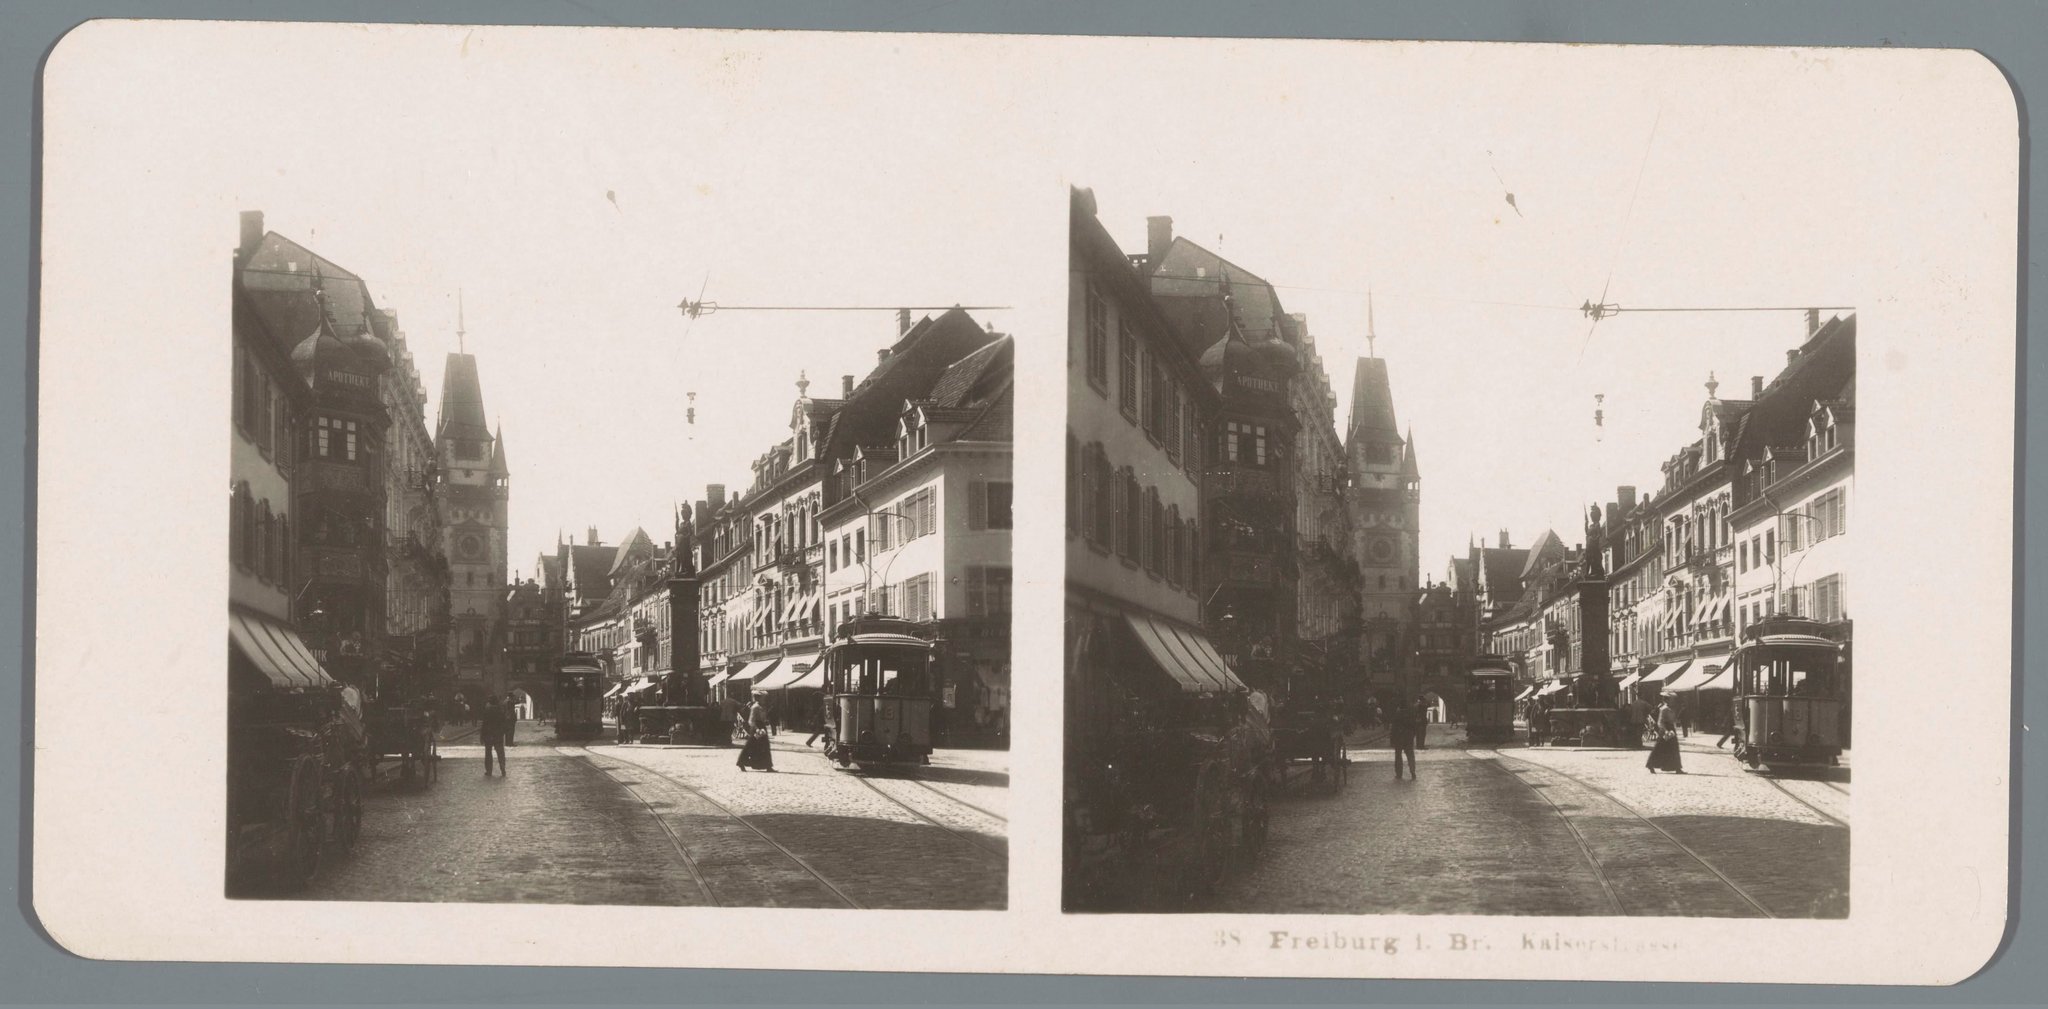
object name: stereograph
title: Gezicht op de Kaiserstraße te Freiburg im Breisgau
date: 1906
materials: cardboard, photographic support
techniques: gelatin silver print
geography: freiburg im breisgau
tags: façade (of house or building), street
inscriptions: inscription: ‘Neue Photographische Gesellschaft A. G., Steglitz-Berlin 1906.’, number: ‘38’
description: RP-F-00-9050 is een ander exemplaar van dezelfde foto.